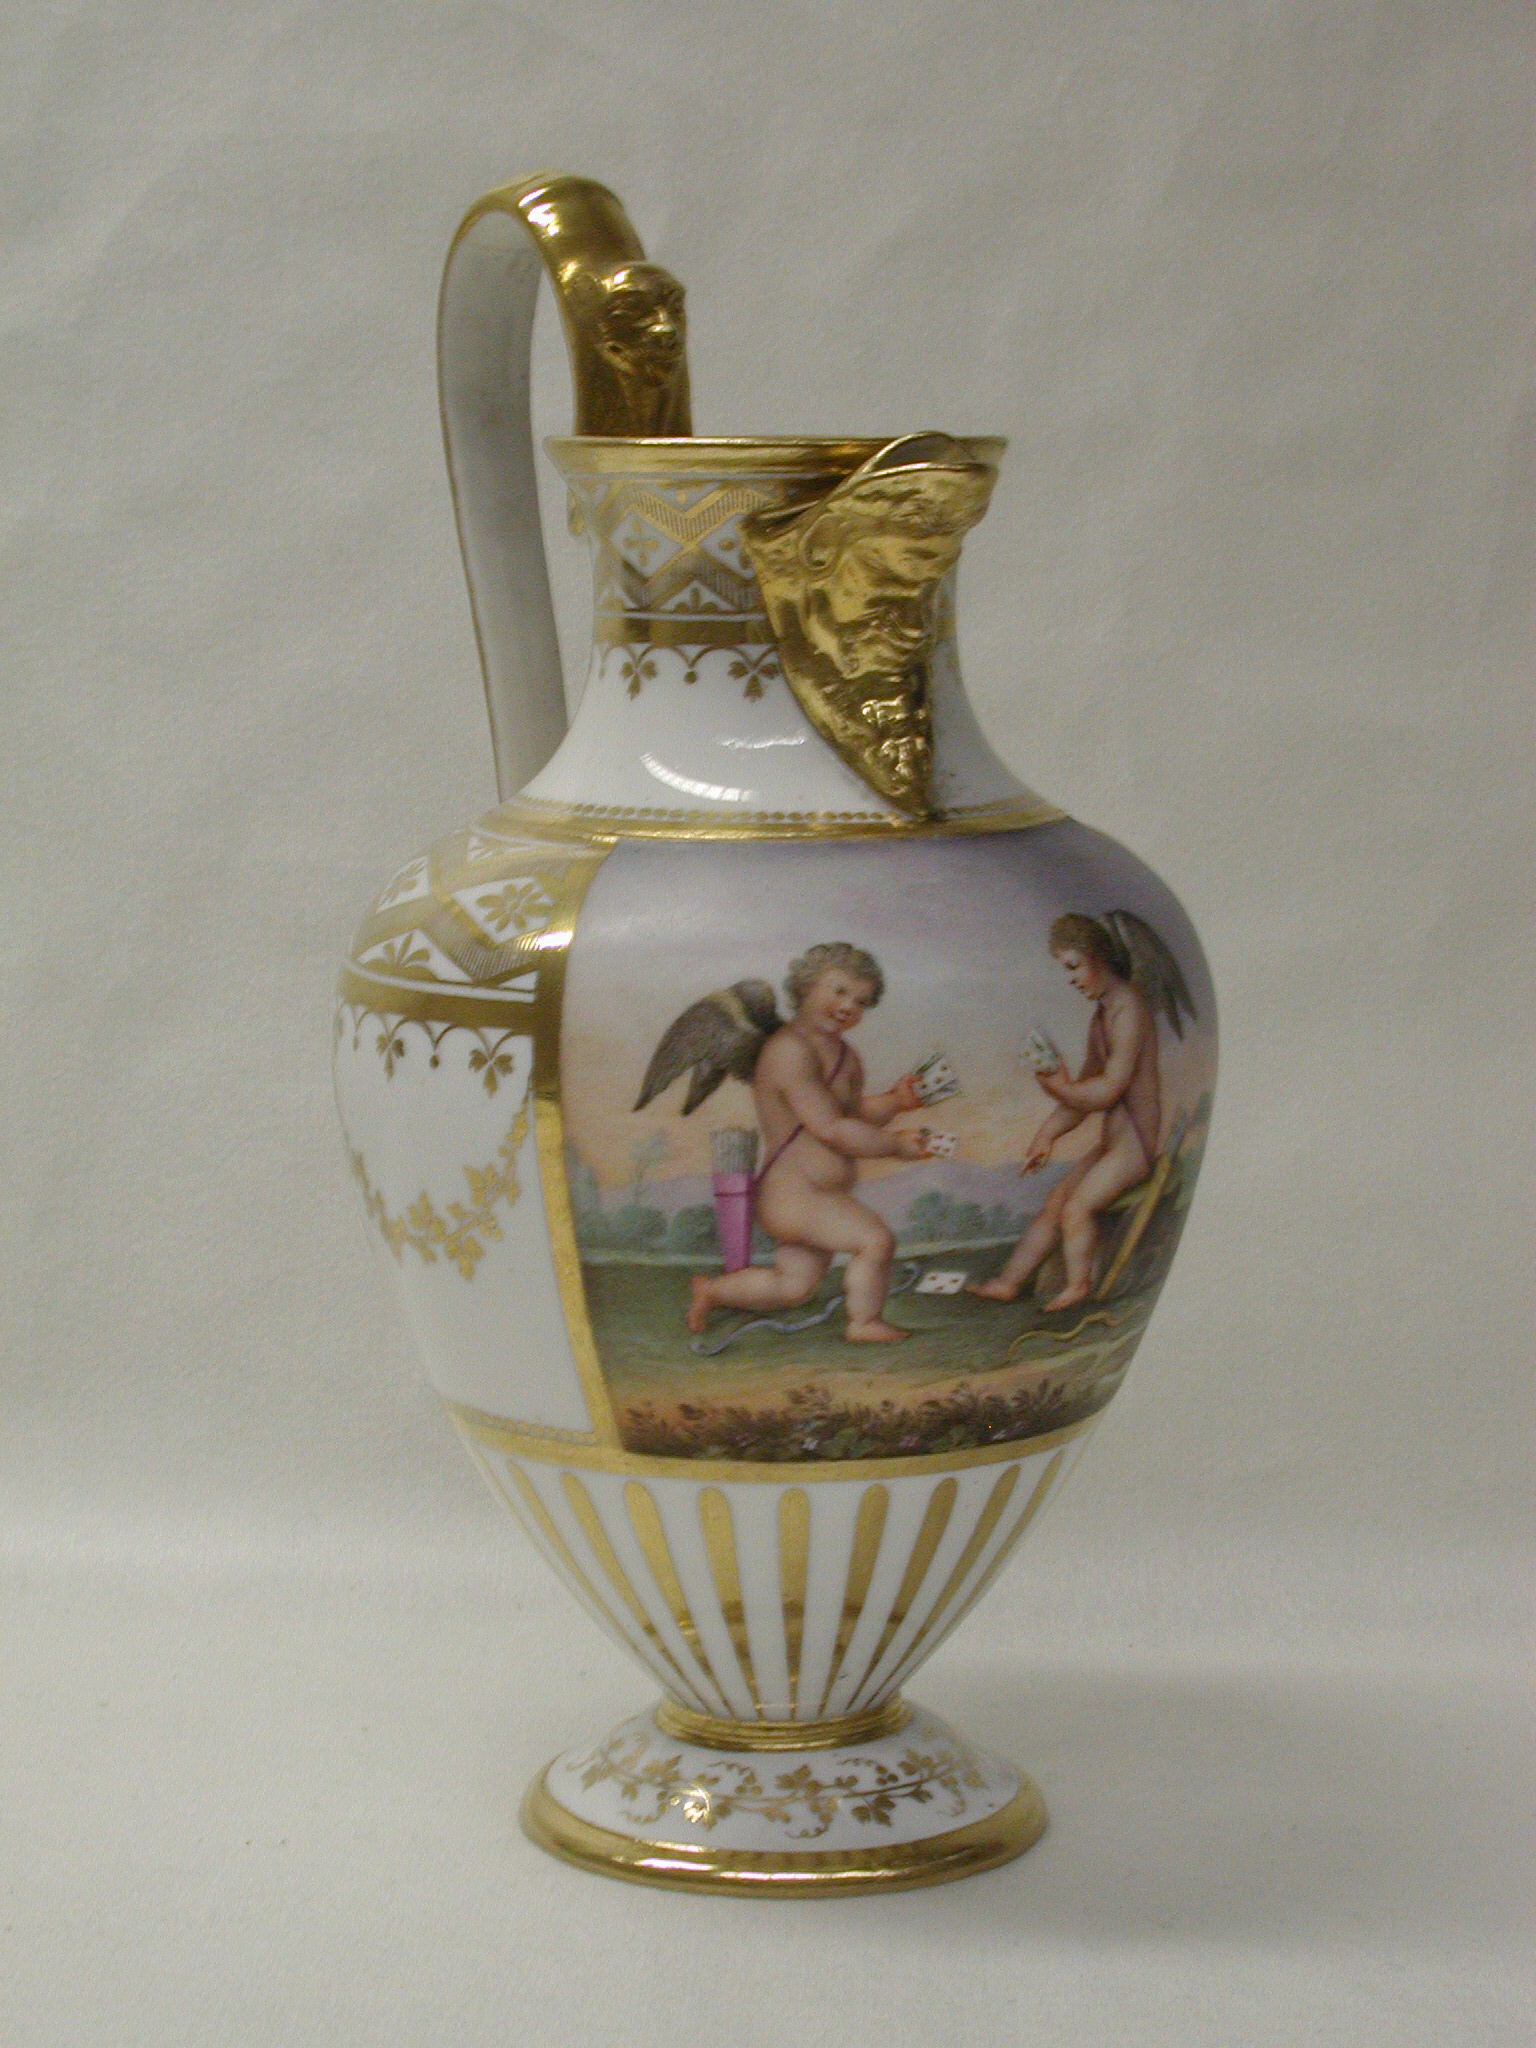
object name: chocolate pot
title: Chocolate pot (part of a service)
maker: royal porcelain manufactory, naples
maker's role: manufactory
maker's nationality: italian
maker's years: 1759-1819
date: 1767-1800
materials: soft paste porcelain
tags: playing cards,putti,games